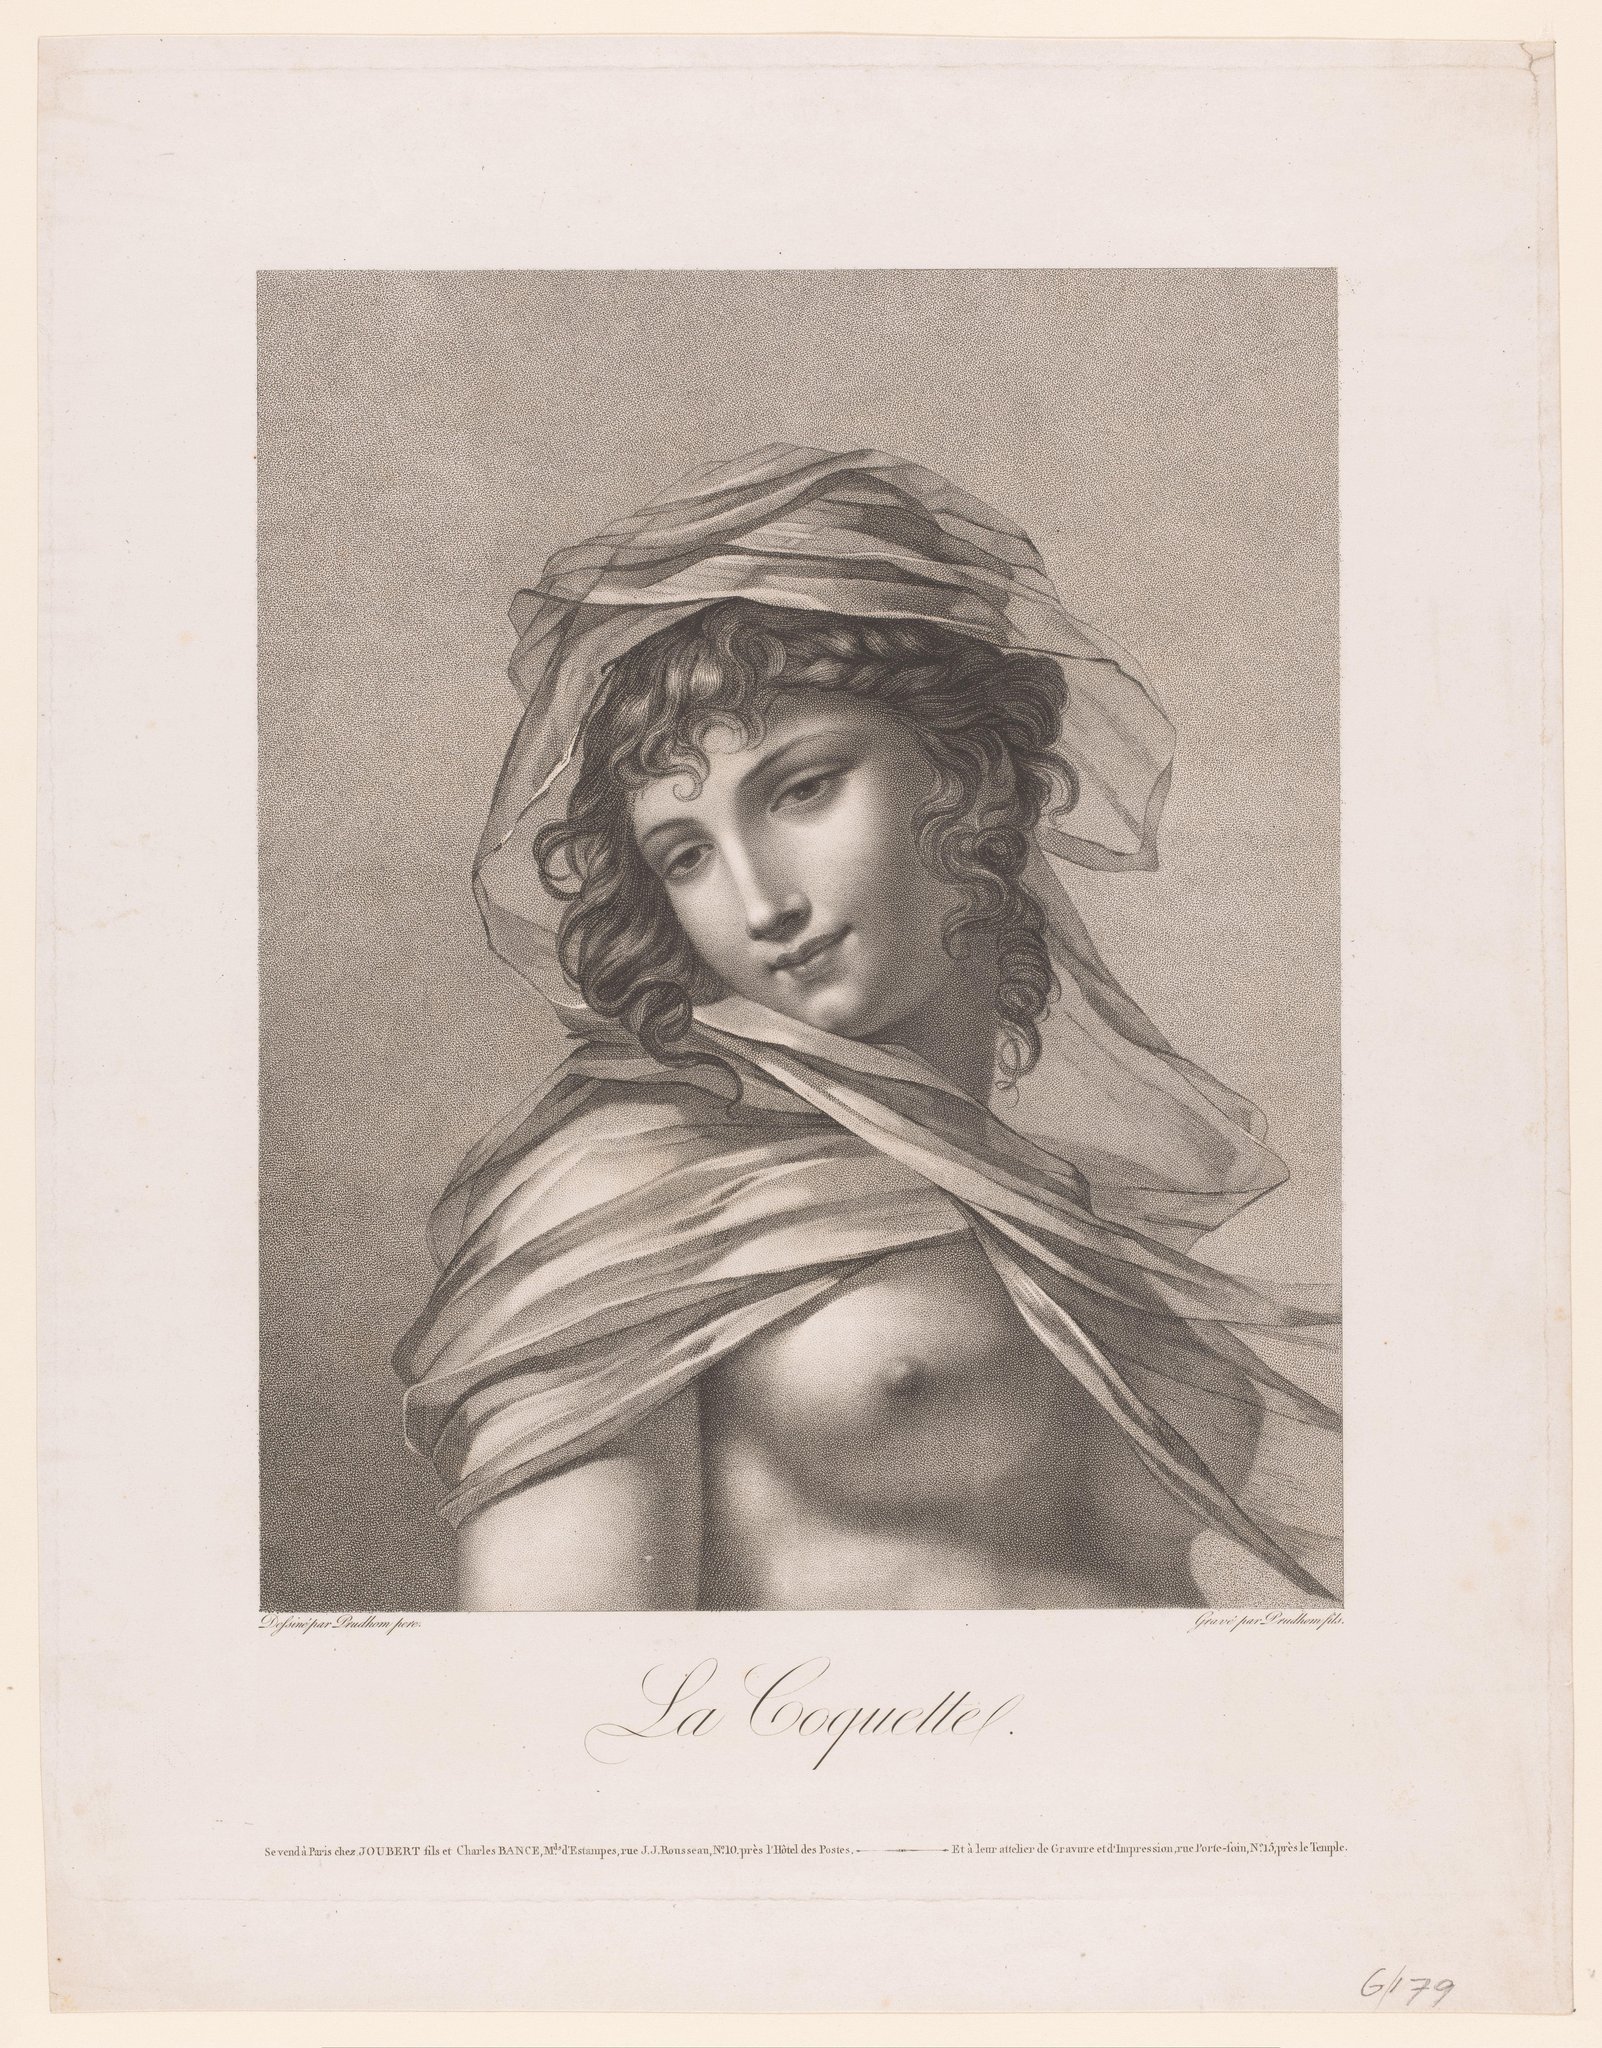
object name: print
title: La Coquette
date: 1788-1824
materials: paper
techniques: etching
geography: paris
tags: woman (showing herself) undressed, quasi-nude, veil, chest, bust - aa - female human figure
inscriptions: collector's mark: Lugt 2228